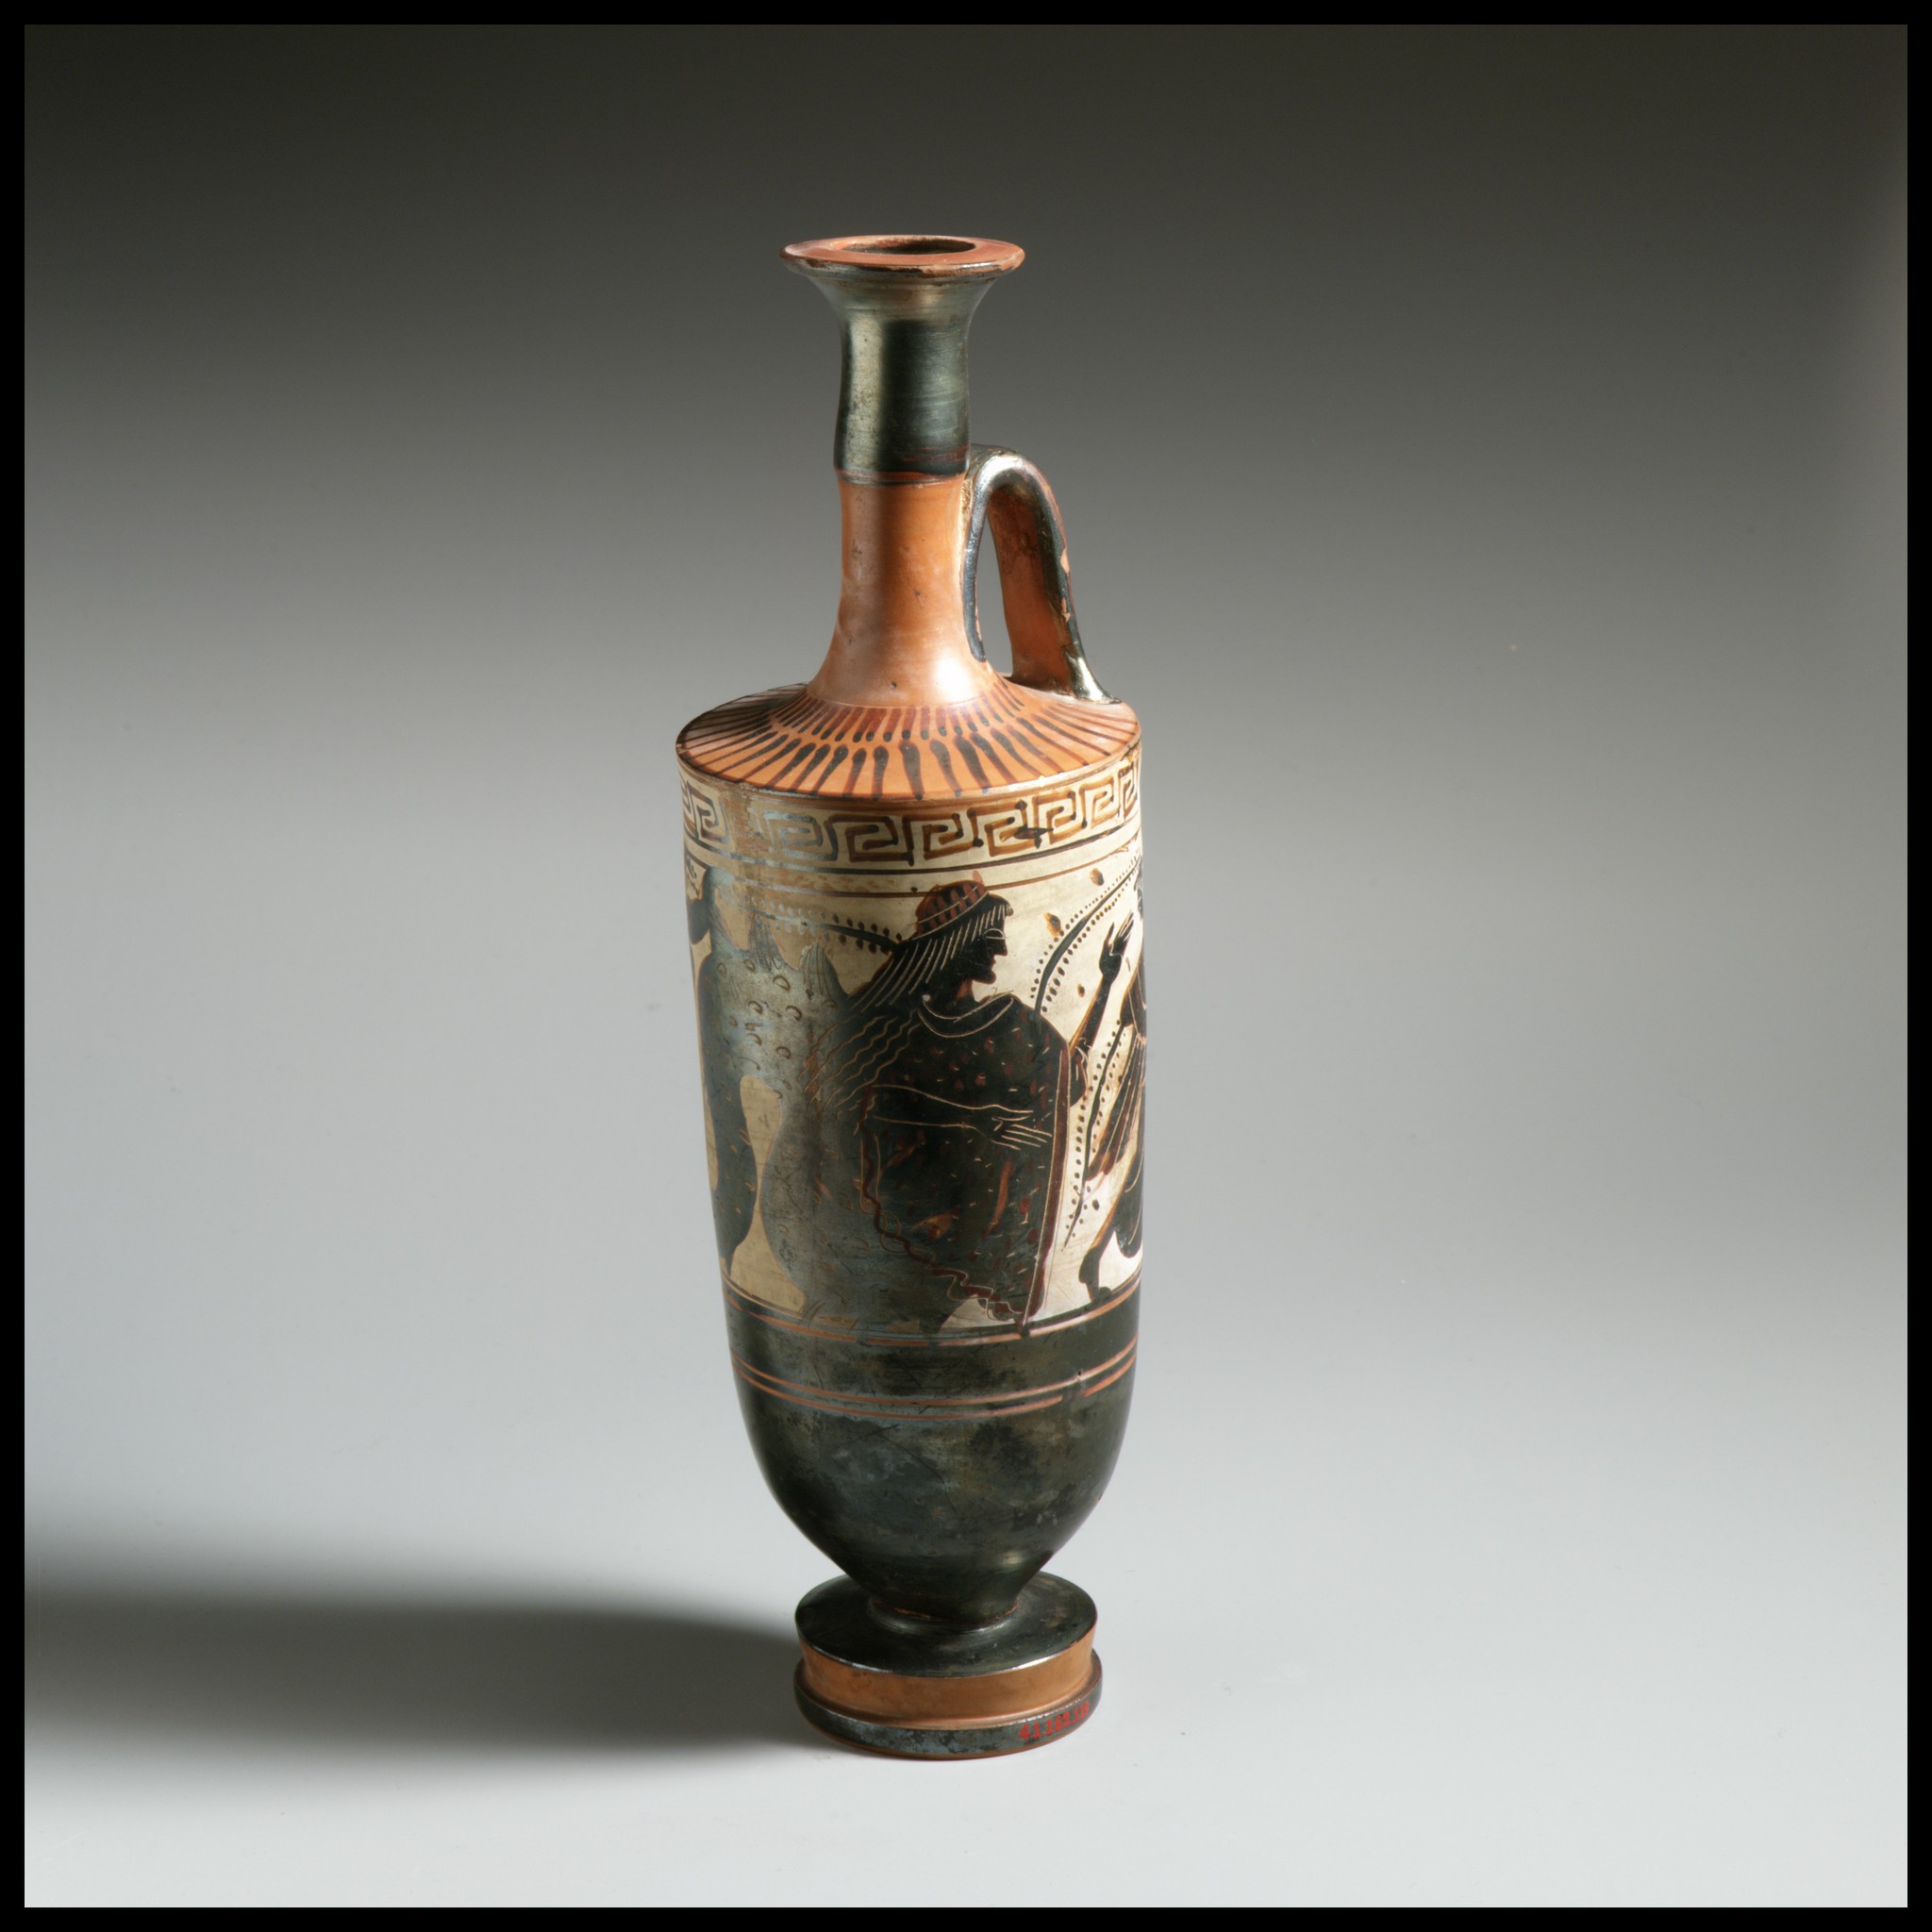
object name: lekythos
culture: greek, attic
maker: emporion painter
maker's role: artist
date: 470 BCE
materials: terracotta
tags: triton